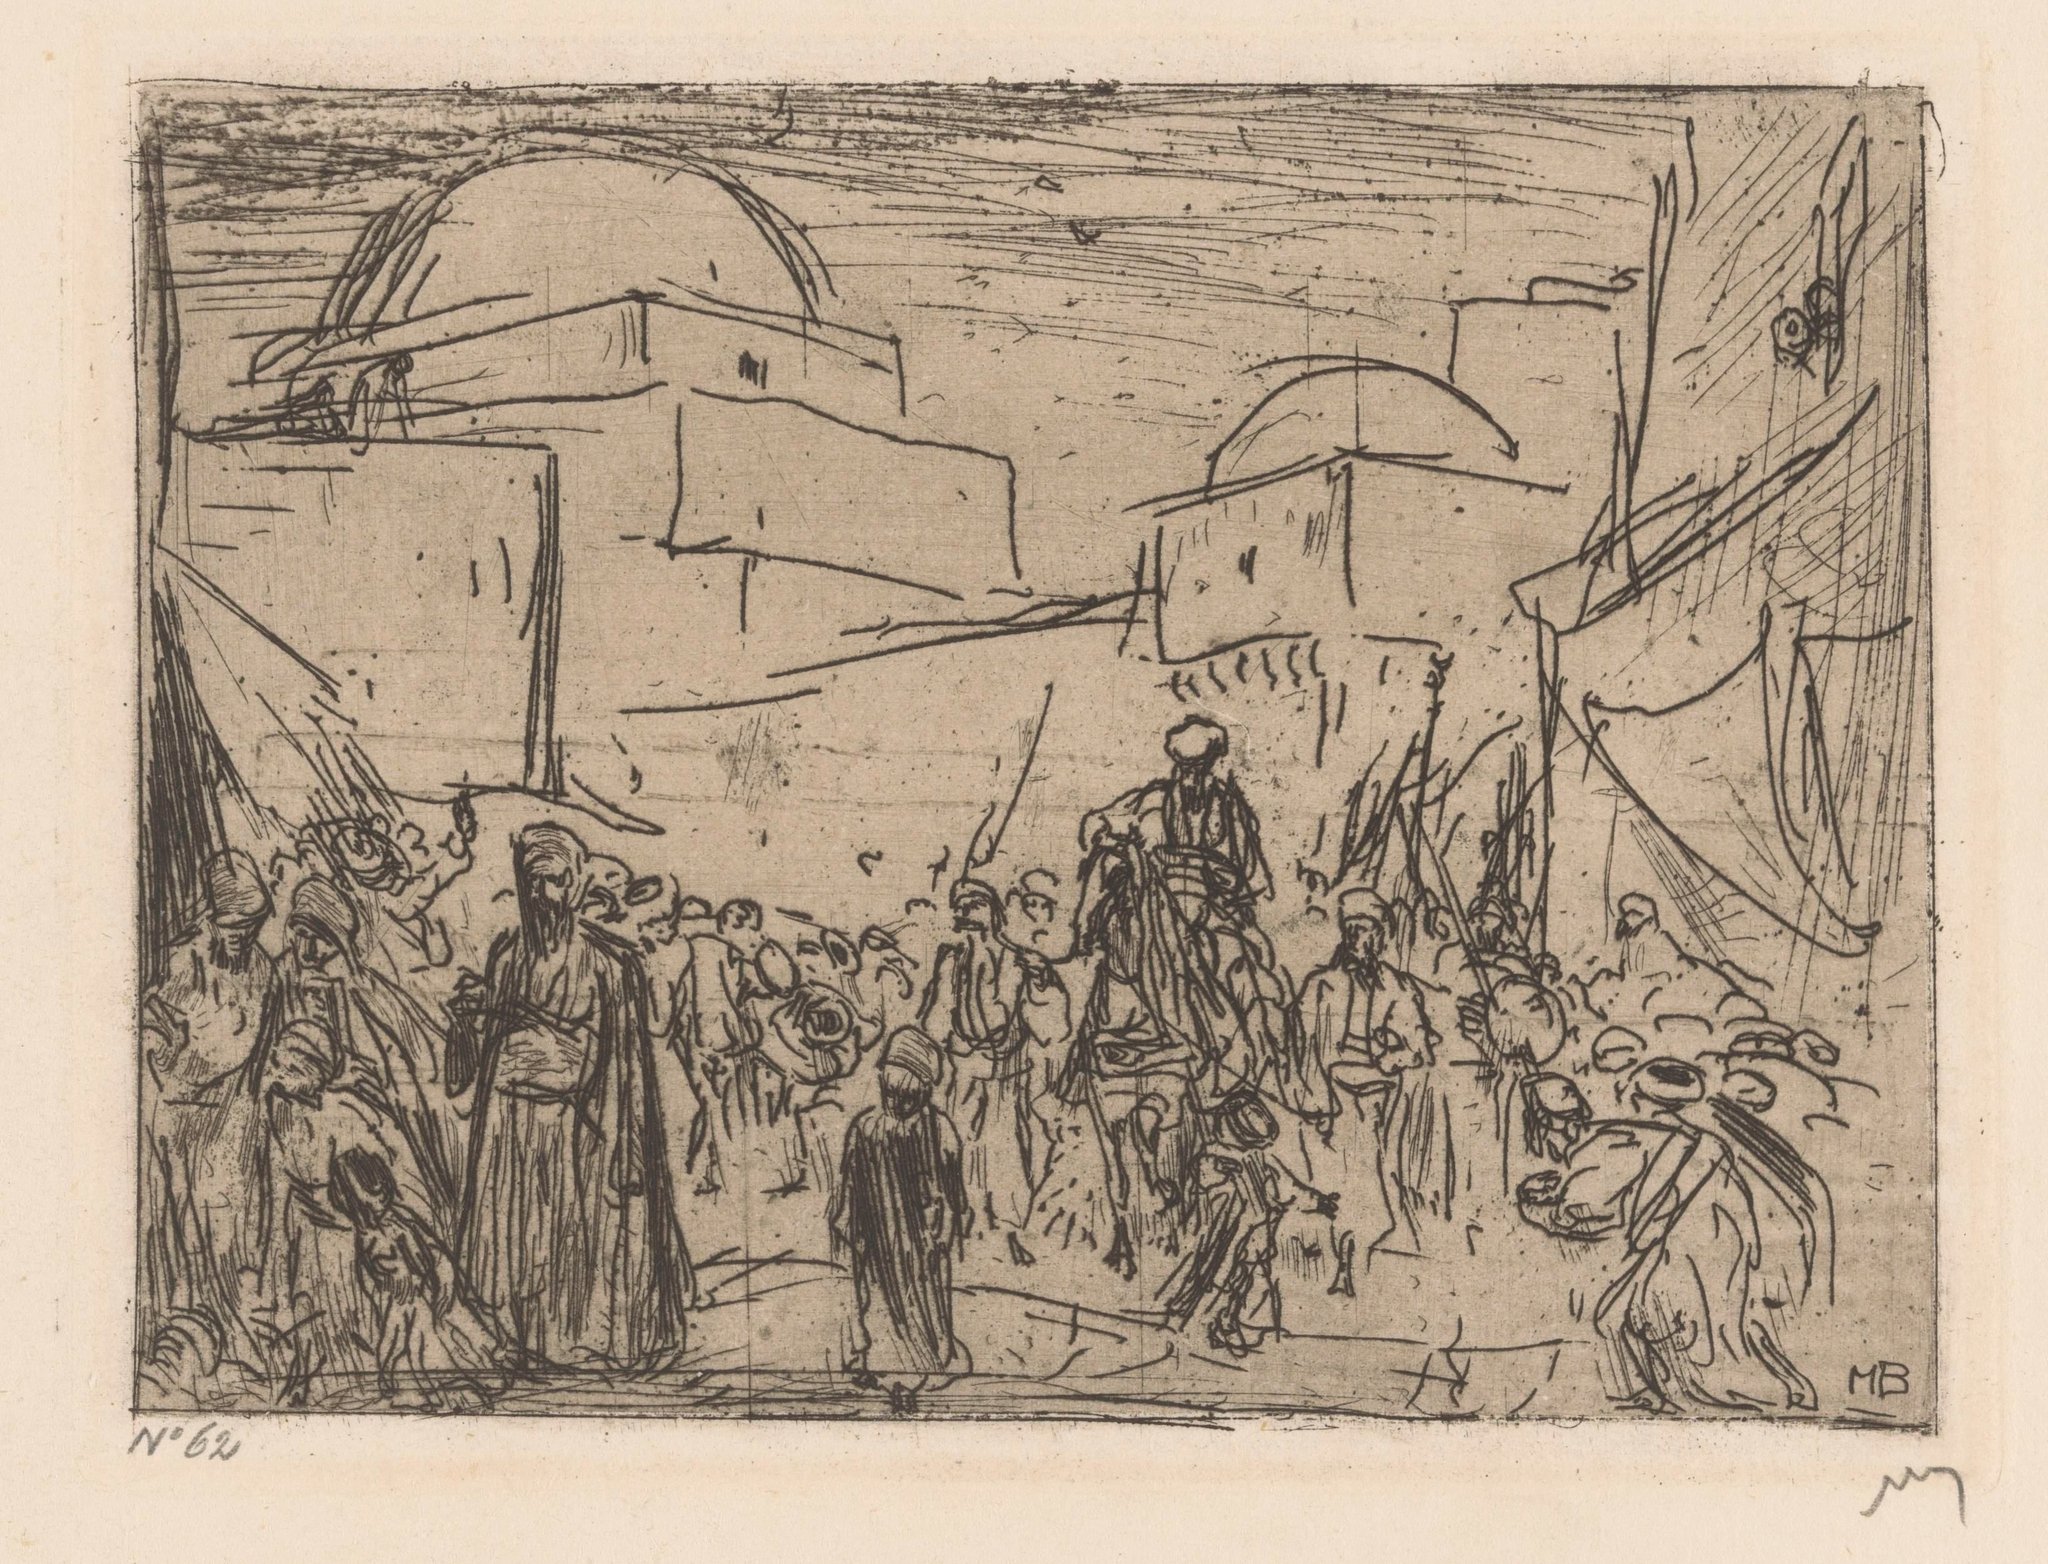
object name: print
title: Vizier op een paard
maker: marius bauer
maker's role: draughtsman, print maker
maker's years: 1867-1932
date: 1889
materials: paper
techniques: etching, intaglio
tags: official; civil servant; functionary (in general)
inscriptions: watermark, collector's mark: Lugt 2228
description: Een vizier rijdt op een paard tussen een menigte mensen in een stad. Op de achtergrond gebouwen met koepels.